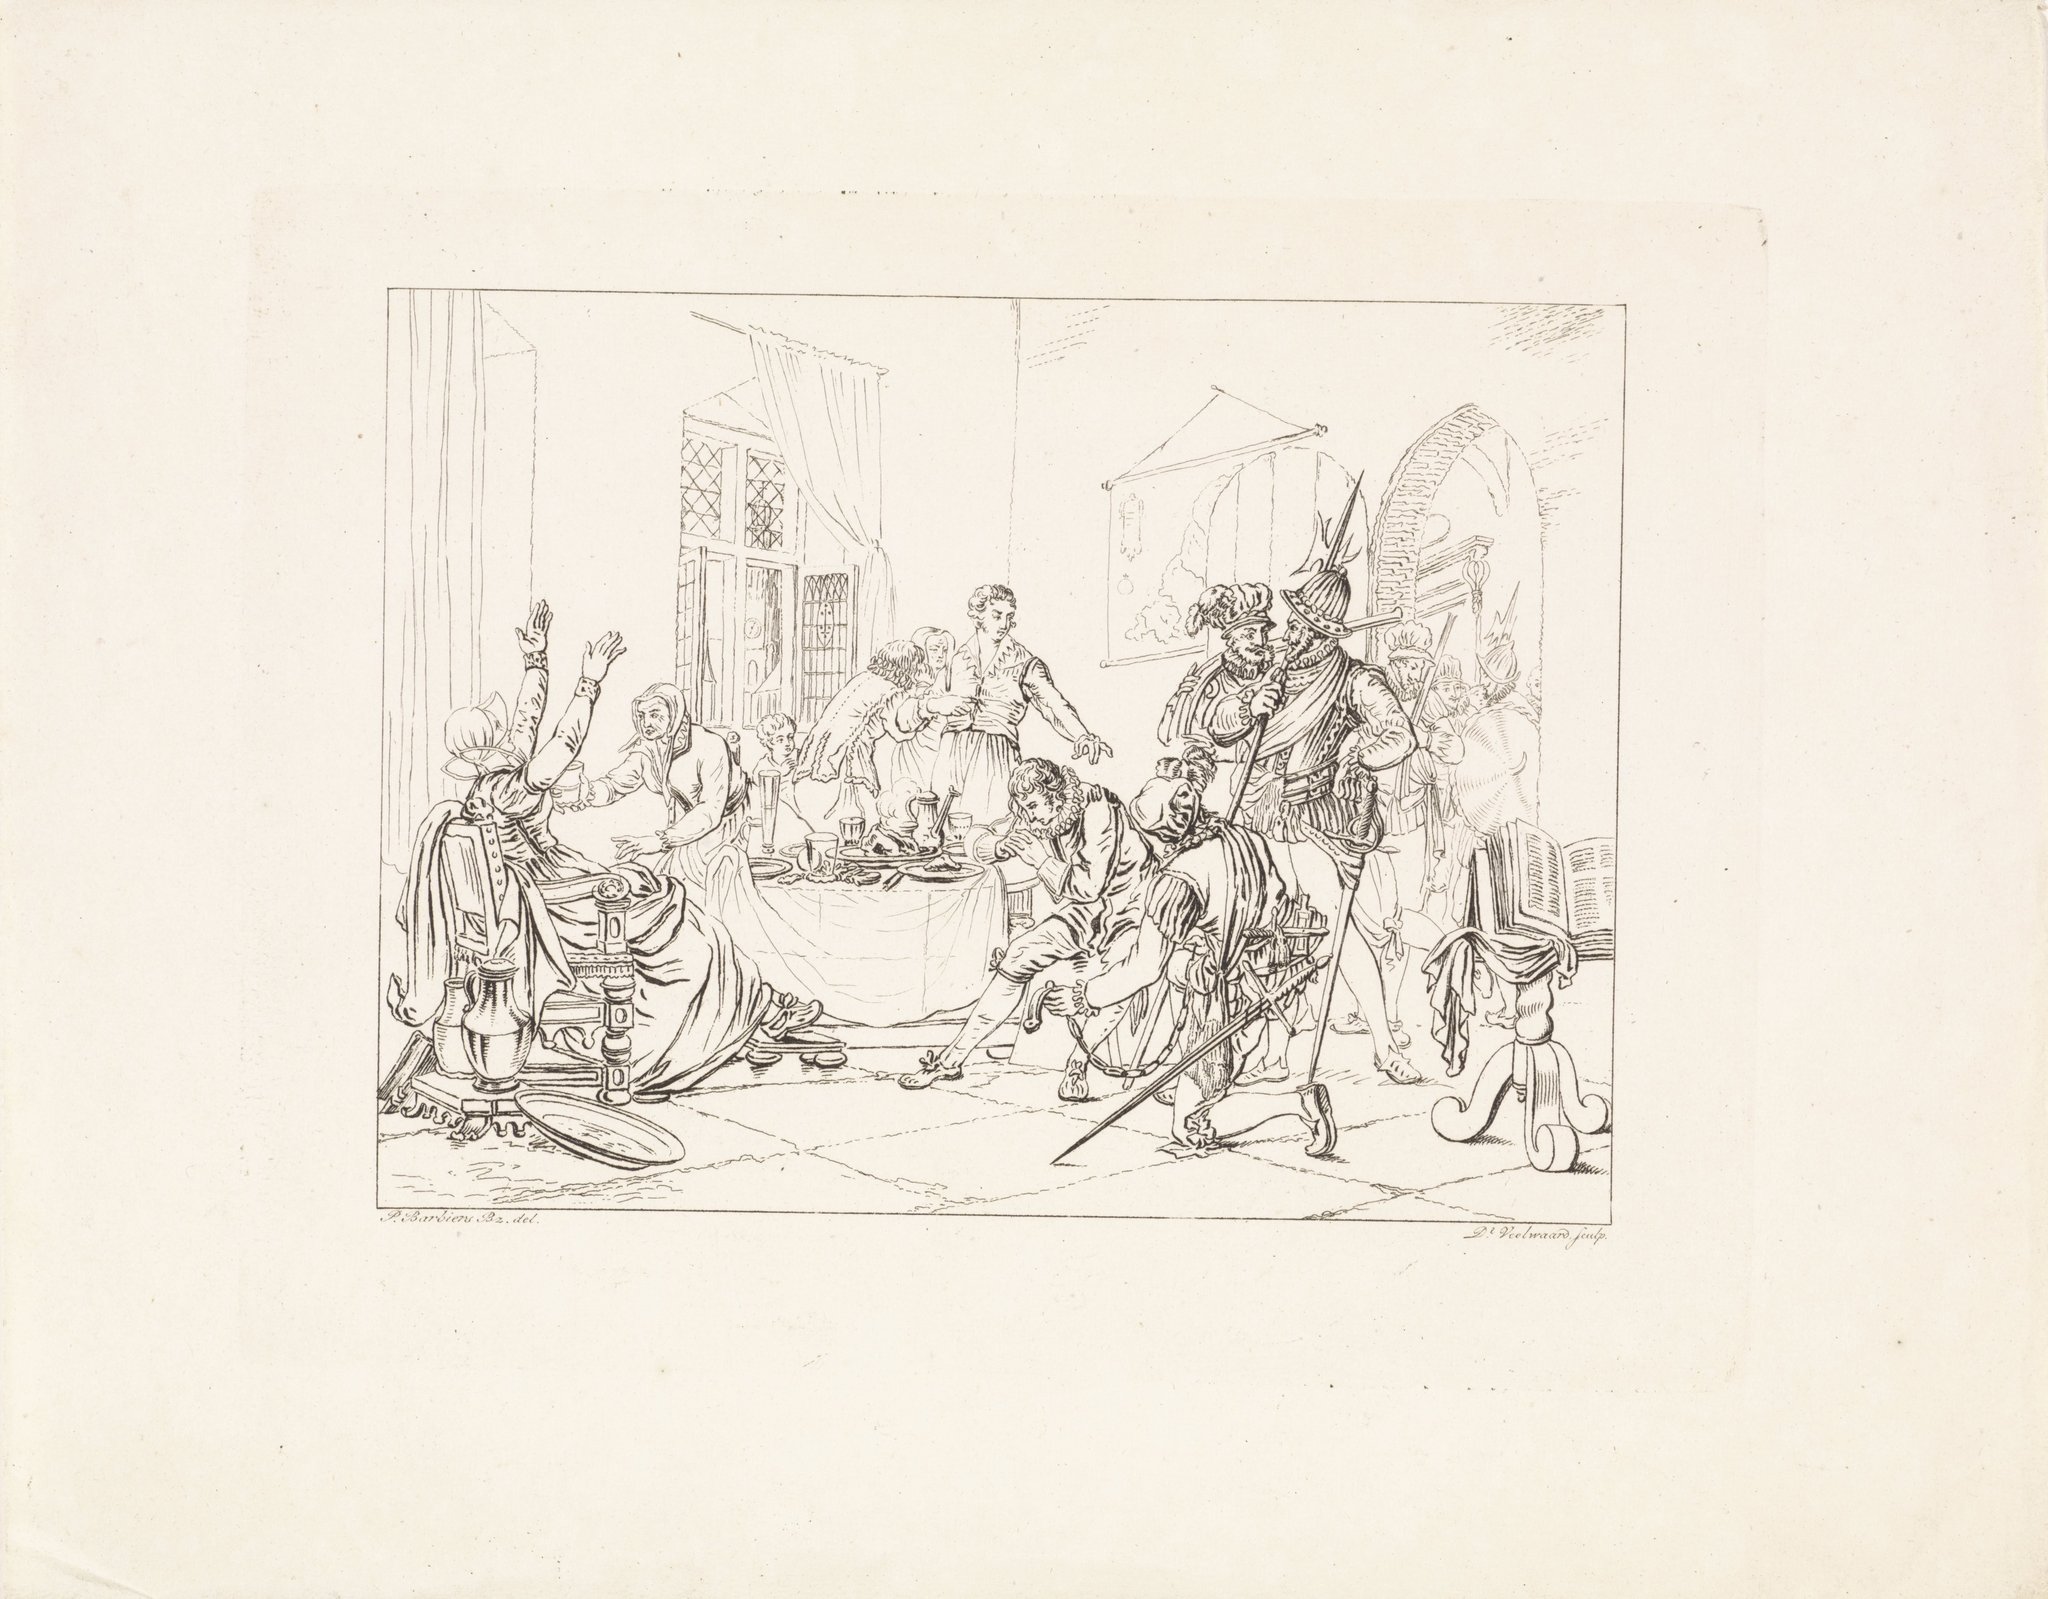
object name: print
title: Interieur met personen rond een tafel en soldaten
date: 1776-1851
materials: paper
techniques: etching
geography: amsterdam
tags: soldiers and civilians, interior of the house, laid table: table-ware, table-decoration, etc.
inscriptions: collector's mark: Lugt 2228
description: Soldaten staan op het punt een jonge man met gevouwen handen in de boeien te slaan. Een vrouw in een stoel bij haar armen in de lucht geheven. Een staande man heeft zijn hand uitgestoken.